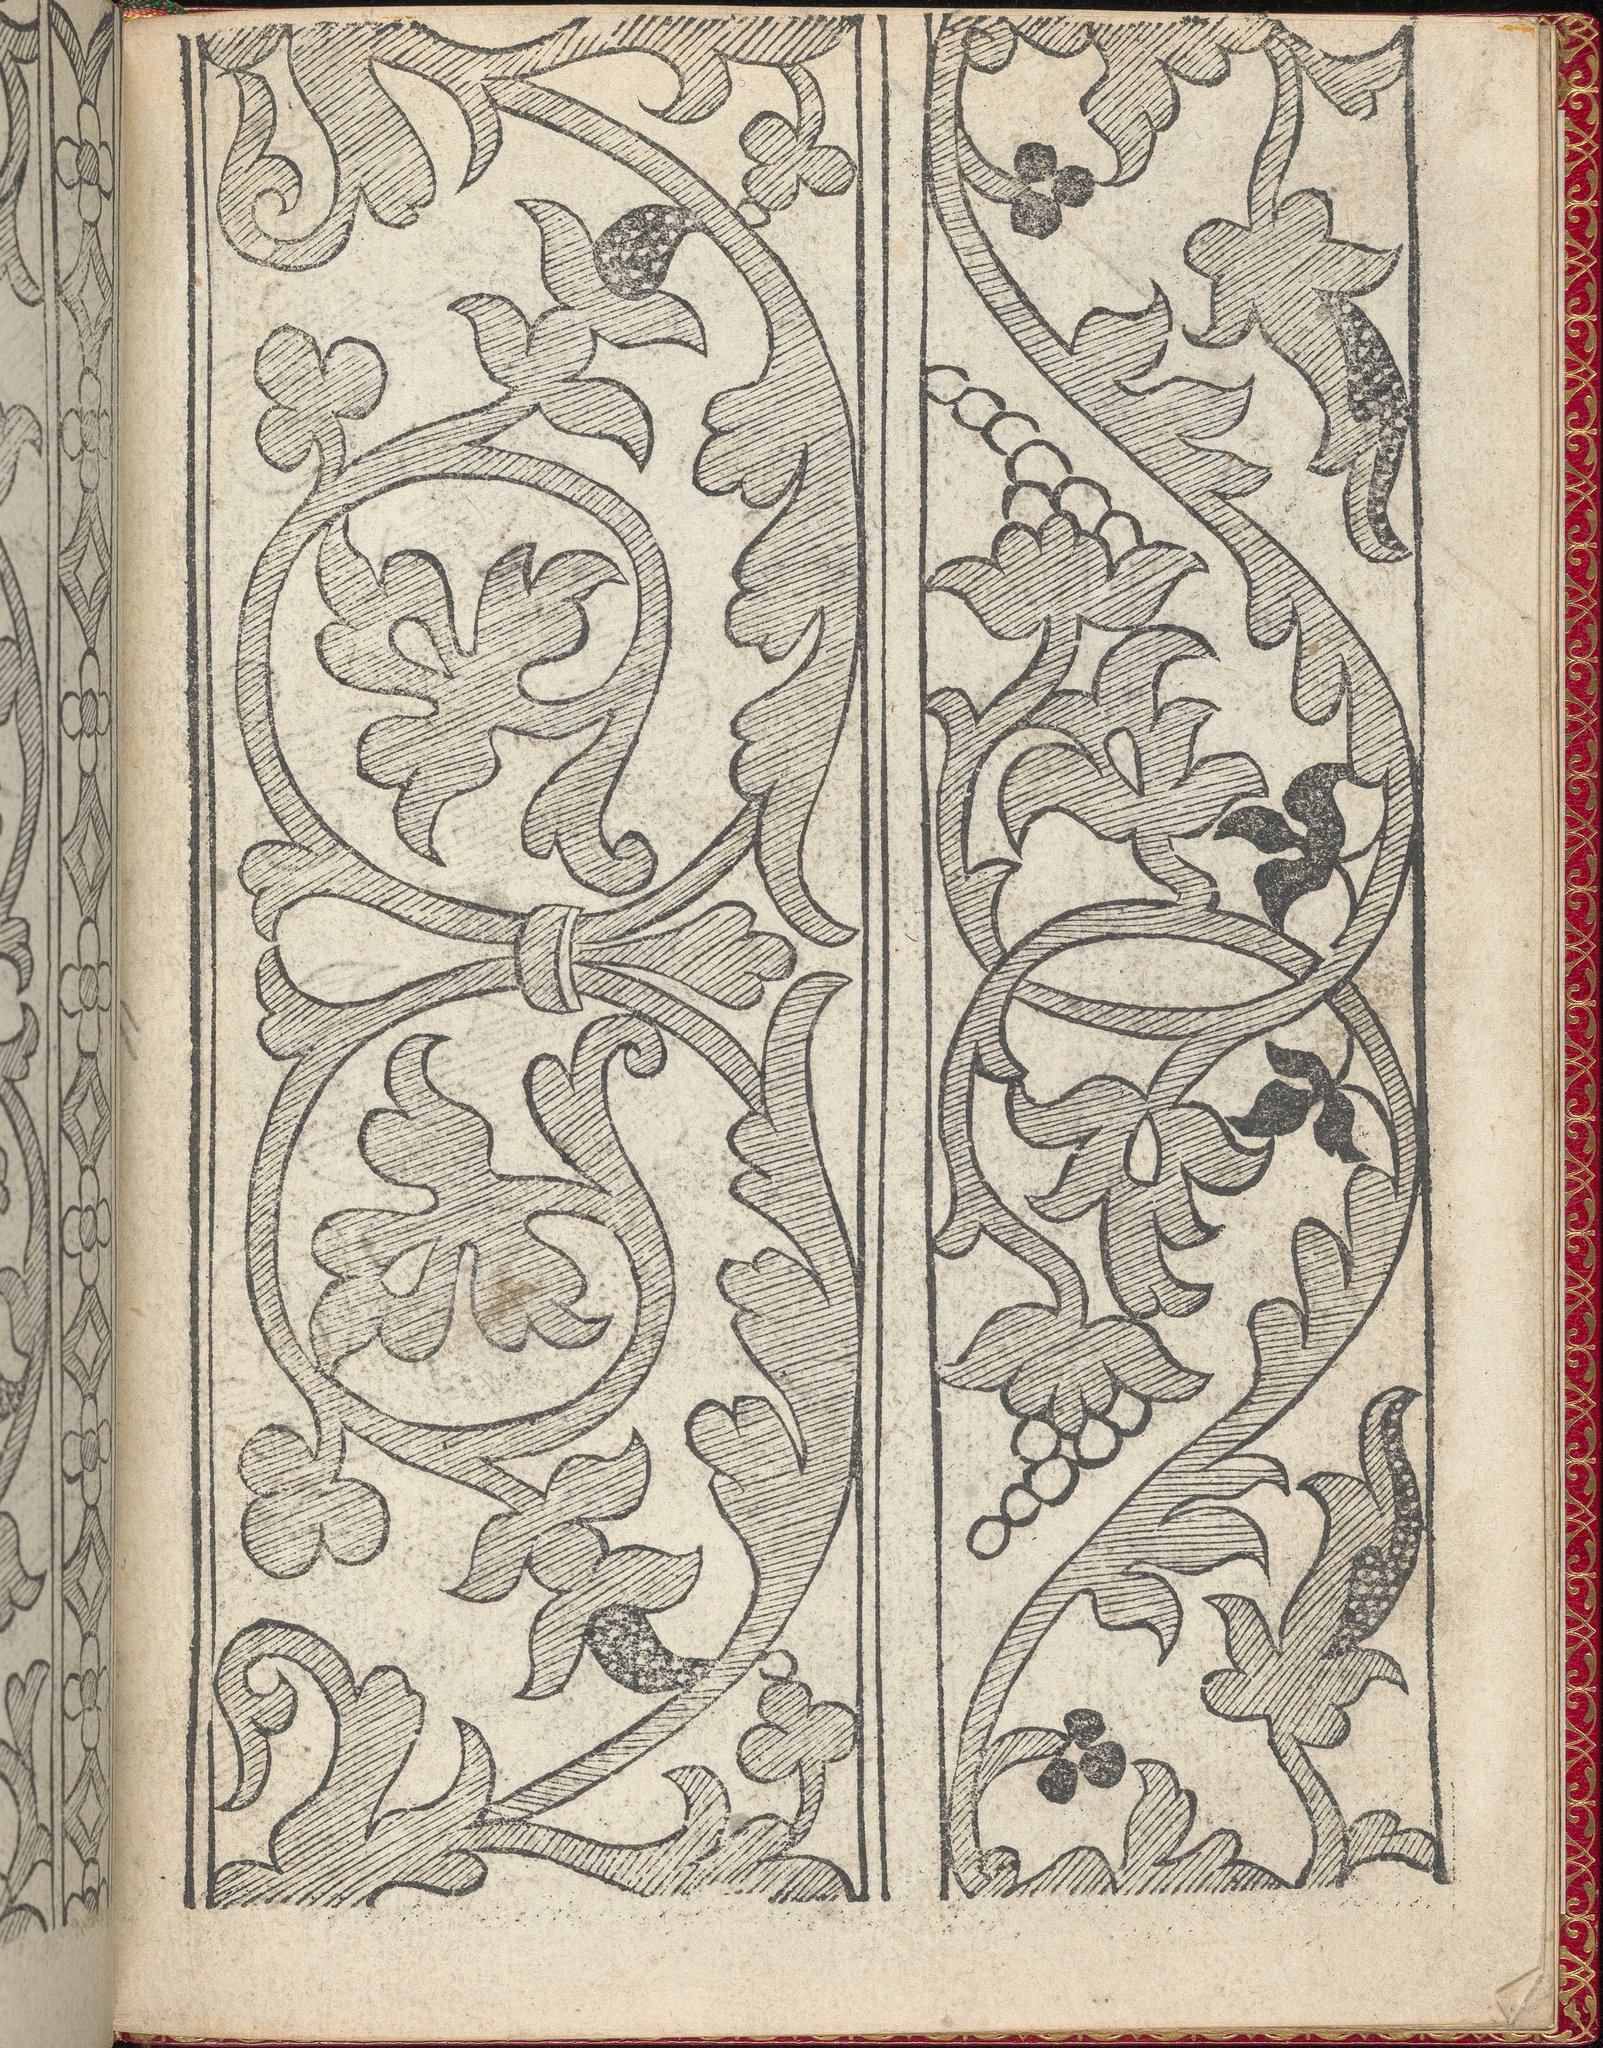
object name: book print ornament architecture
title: Il Monte. Opera Nova di Recami, page 11 (recto)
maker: giovanni antonio bindoni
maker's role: designer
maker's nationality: italian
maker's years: 1500-1650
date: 1557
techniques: woodcut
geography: italy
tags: grapes,flowers,vines